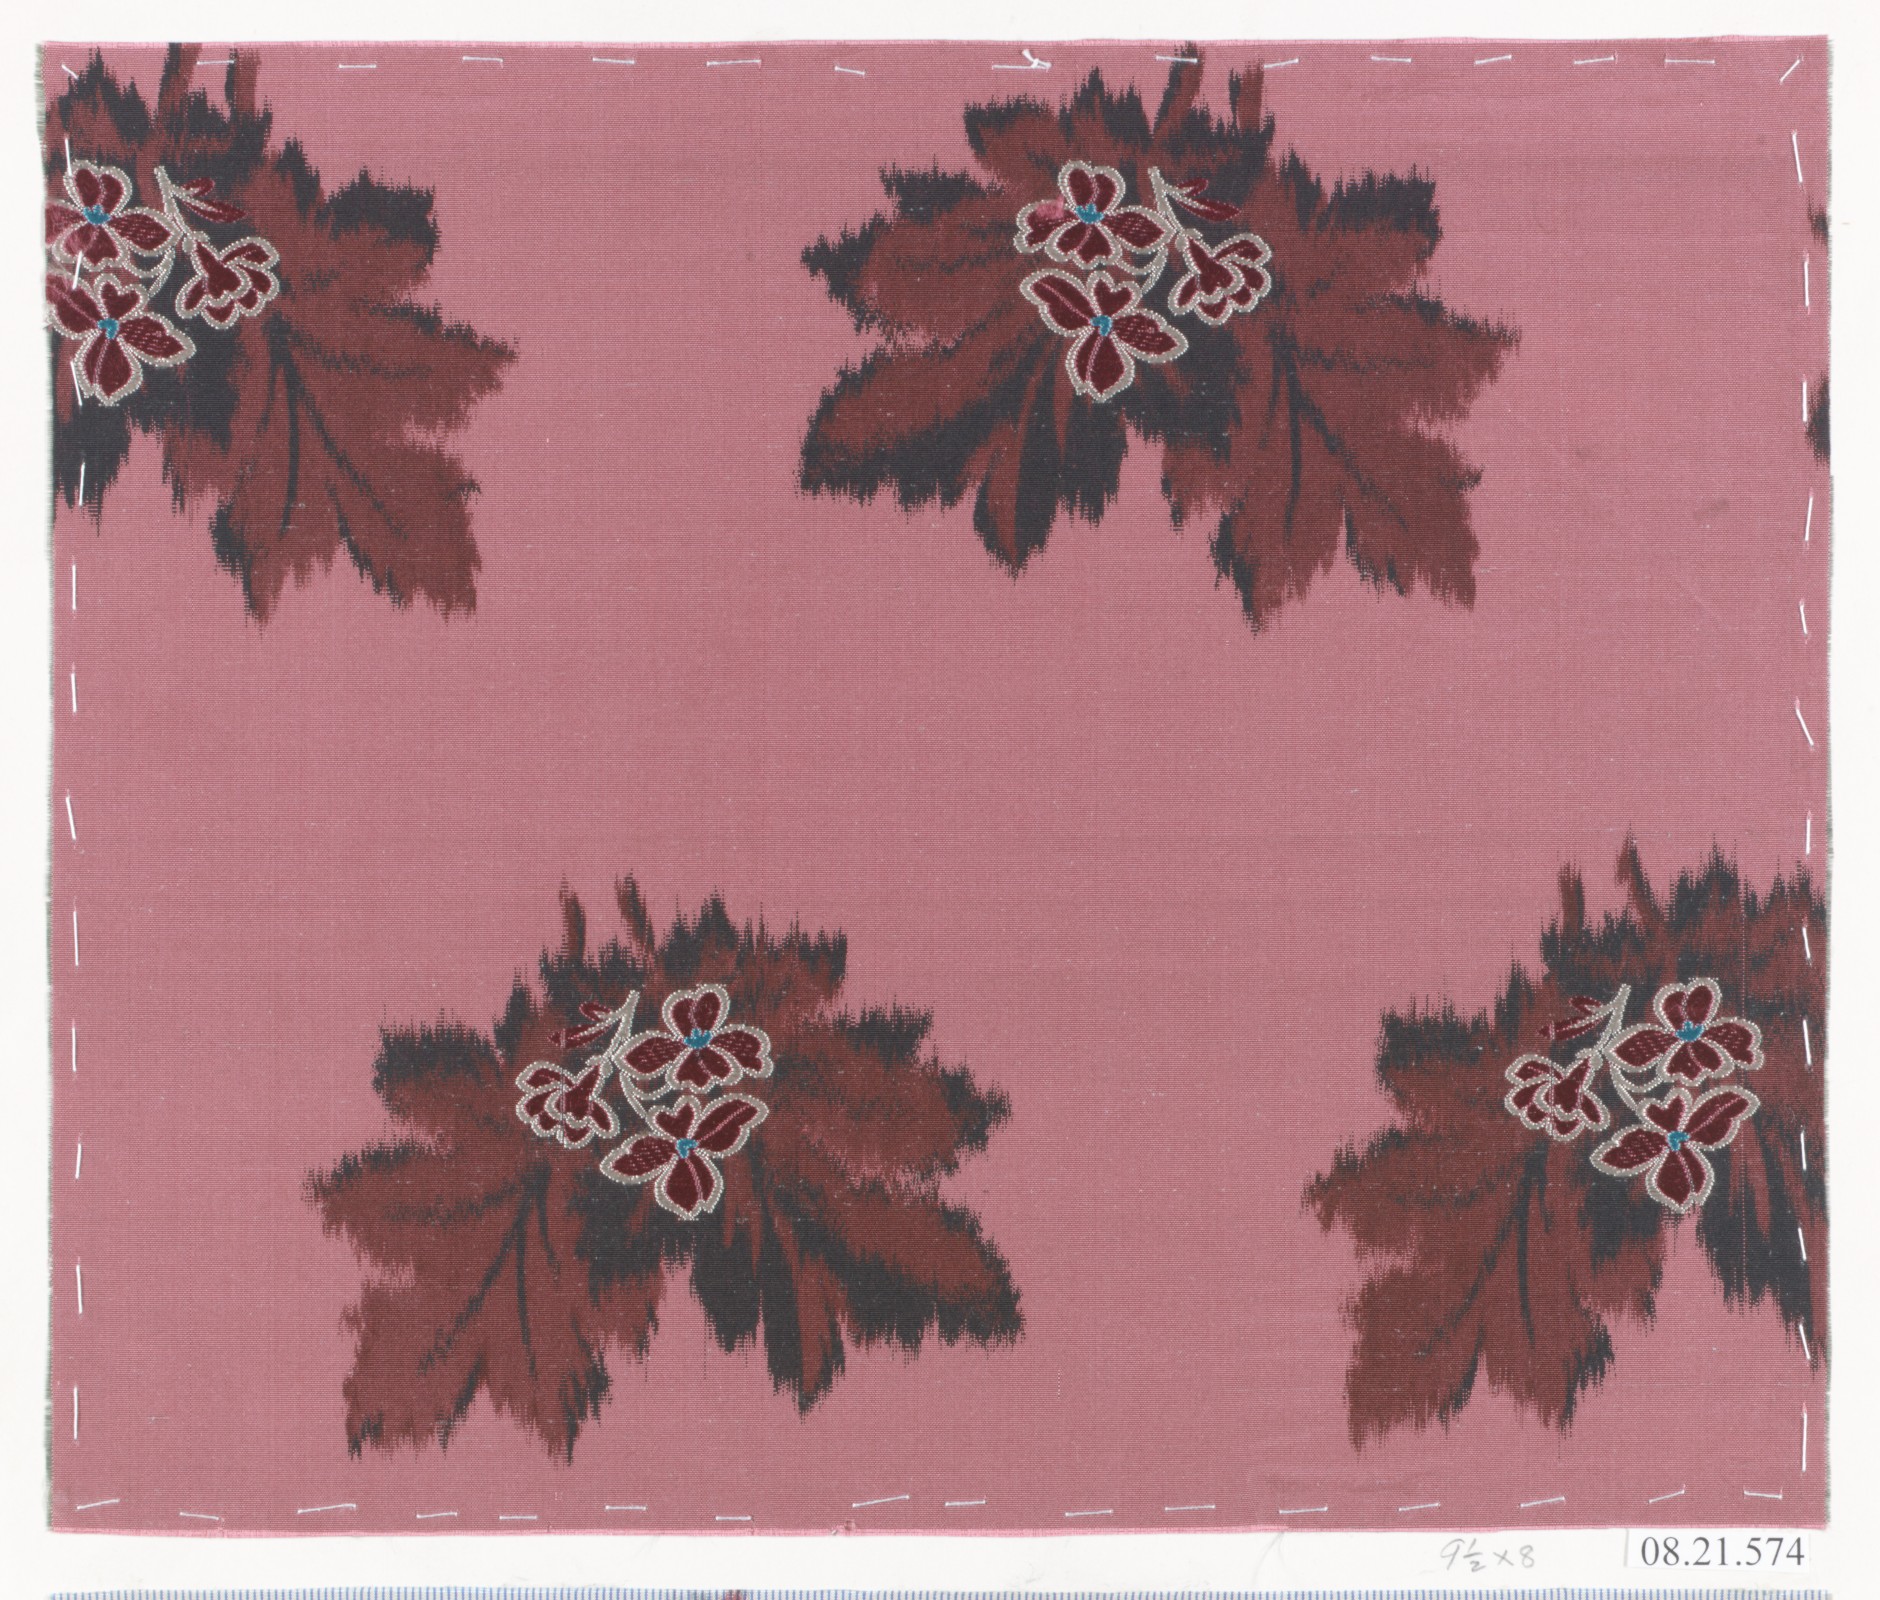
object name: textile sample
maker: Anonymous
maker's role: designer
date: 1900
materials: silk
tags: flowers,leaves